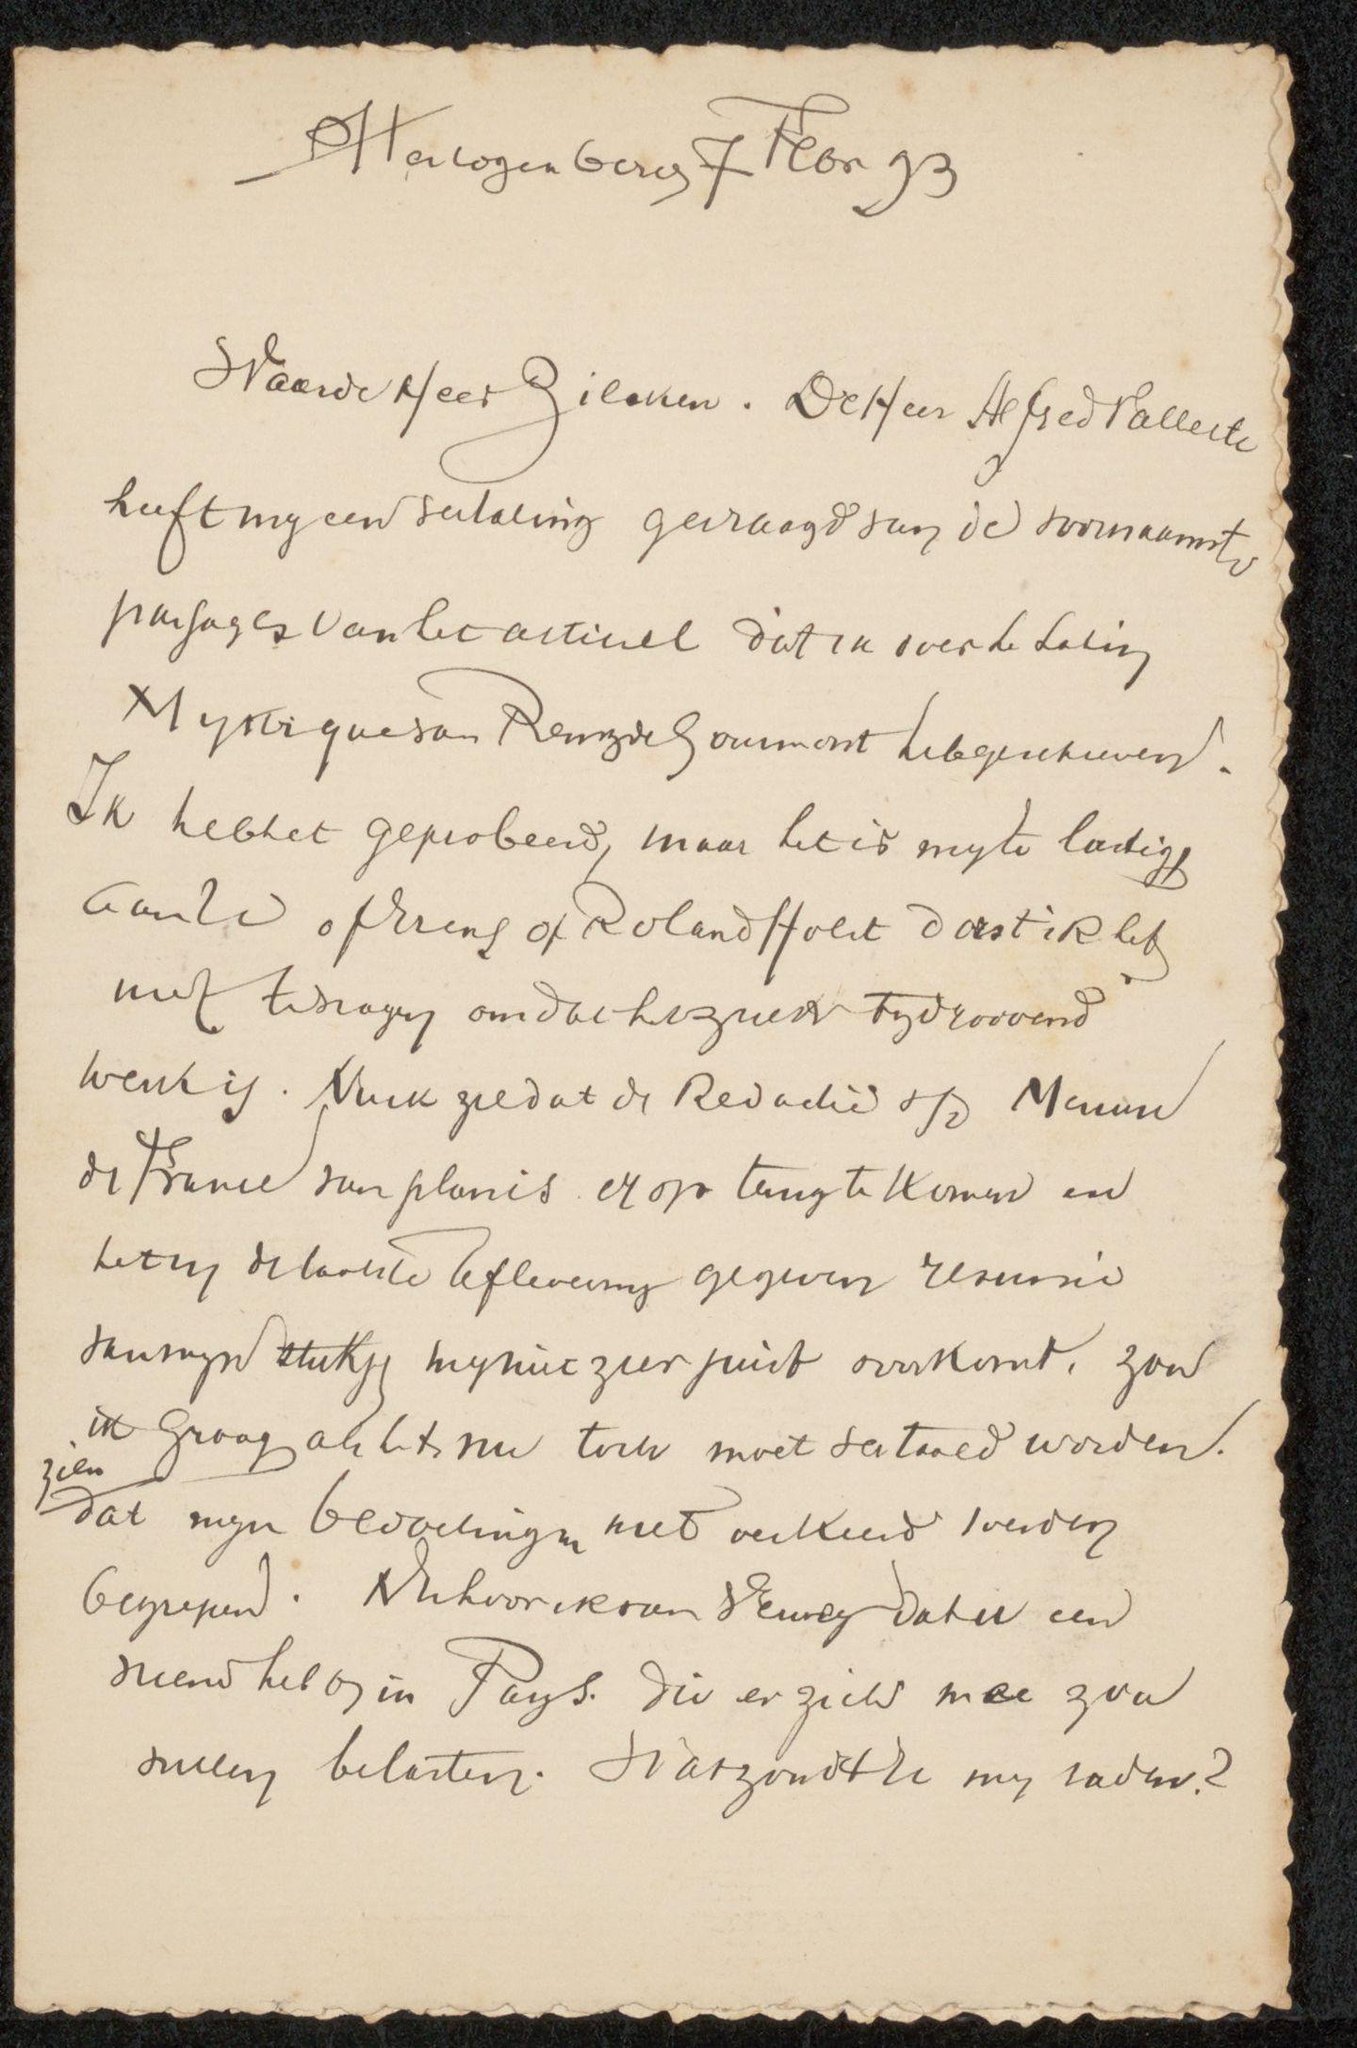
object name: letter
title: Brief aan Philip Zilcken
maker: alphons diepenbrock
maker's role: componist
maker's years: 1862-1921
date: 1893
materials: ink, paper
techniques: pen, writing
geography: den bosch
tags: the hague, nijmegen, print maker, adriaan pit, adriaan roland holst, paris, draughtsman, philip zilcken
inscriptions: collector's mark: ‘RPK’